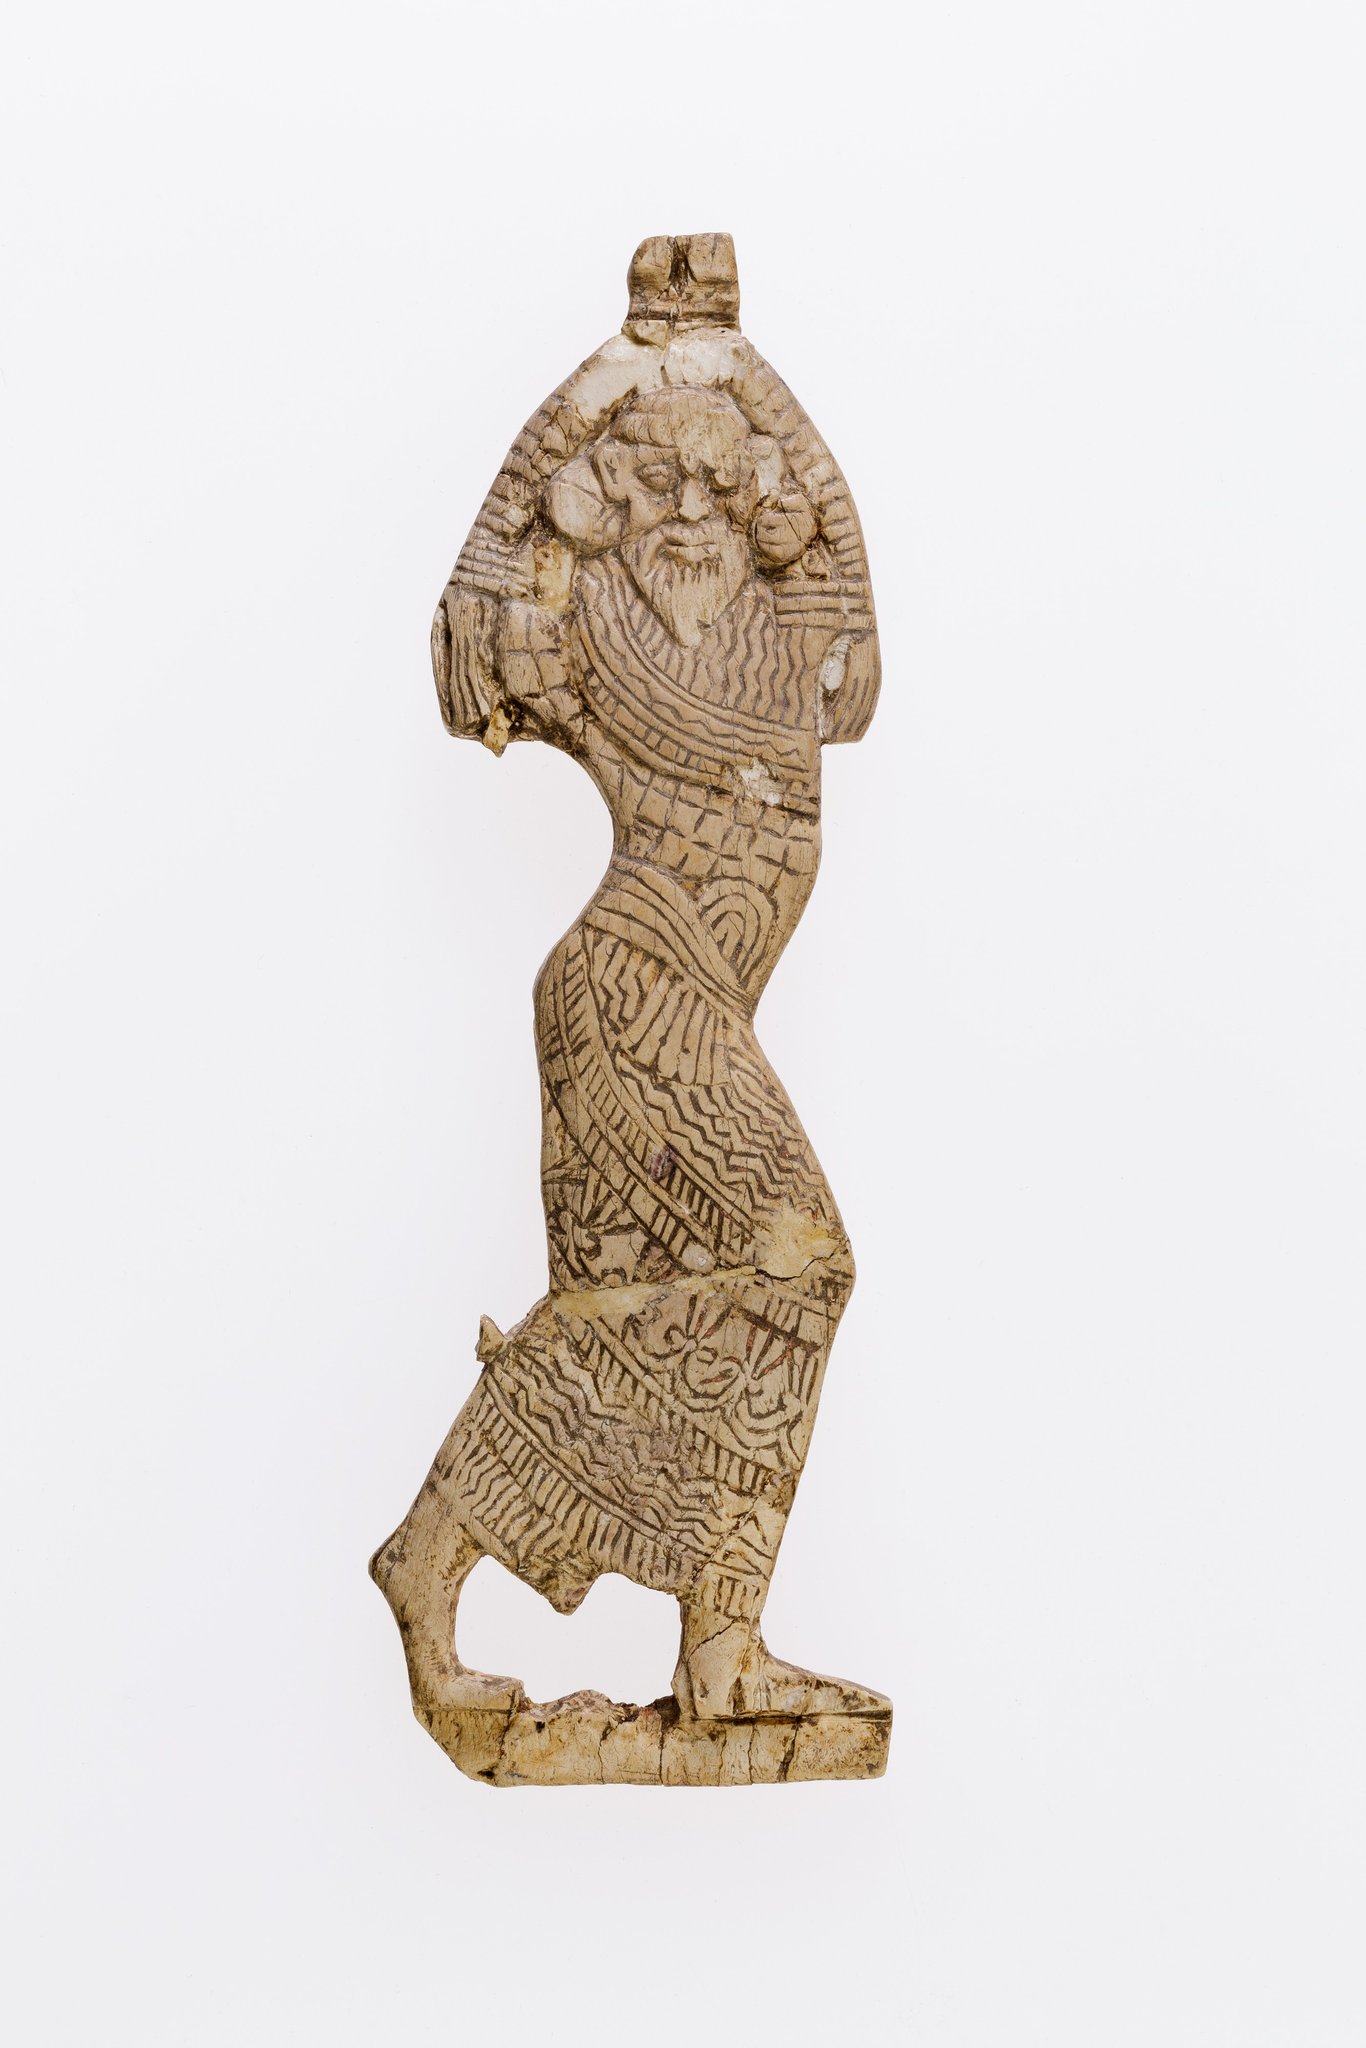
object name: asiatic captive, furniture decoration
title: Figure of an Asiatic captive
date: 1295-1070 BCE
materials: ivory, pigment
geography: egypt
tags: men